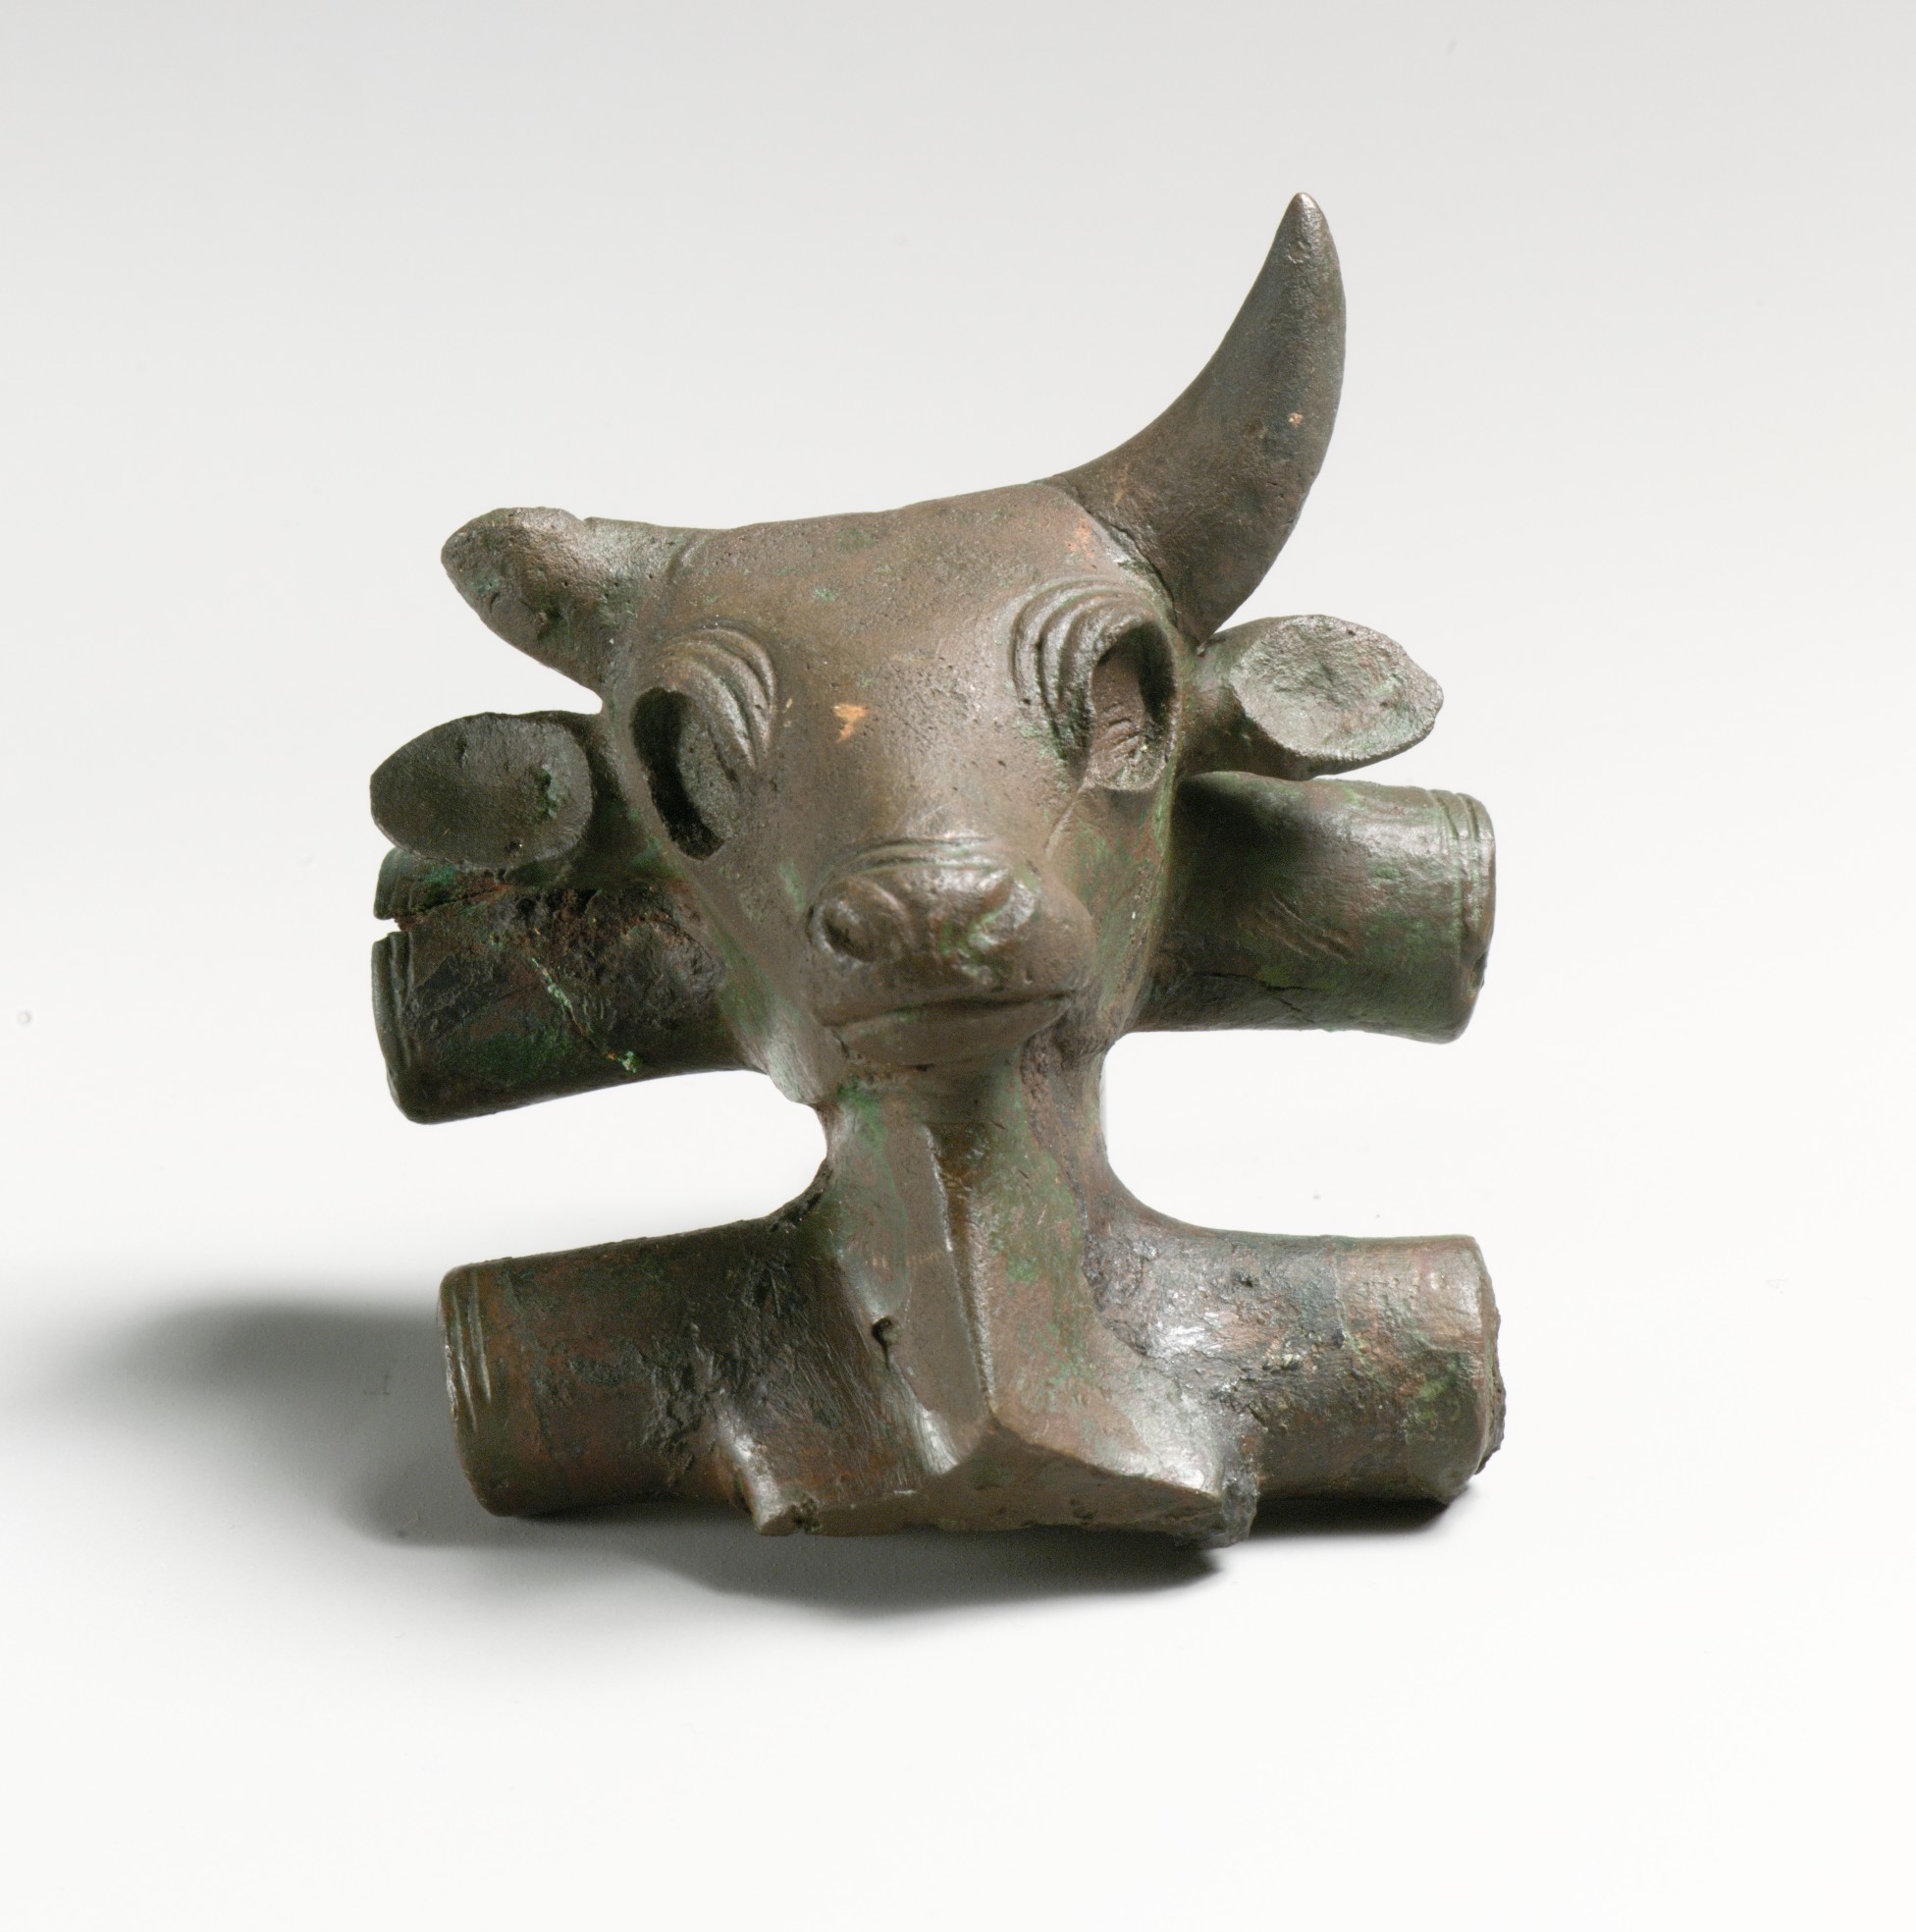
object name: attachment in the form of a bull's head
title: Bronze bull's head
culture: cypriot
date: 700-668 BCE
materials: bronze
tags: bulls